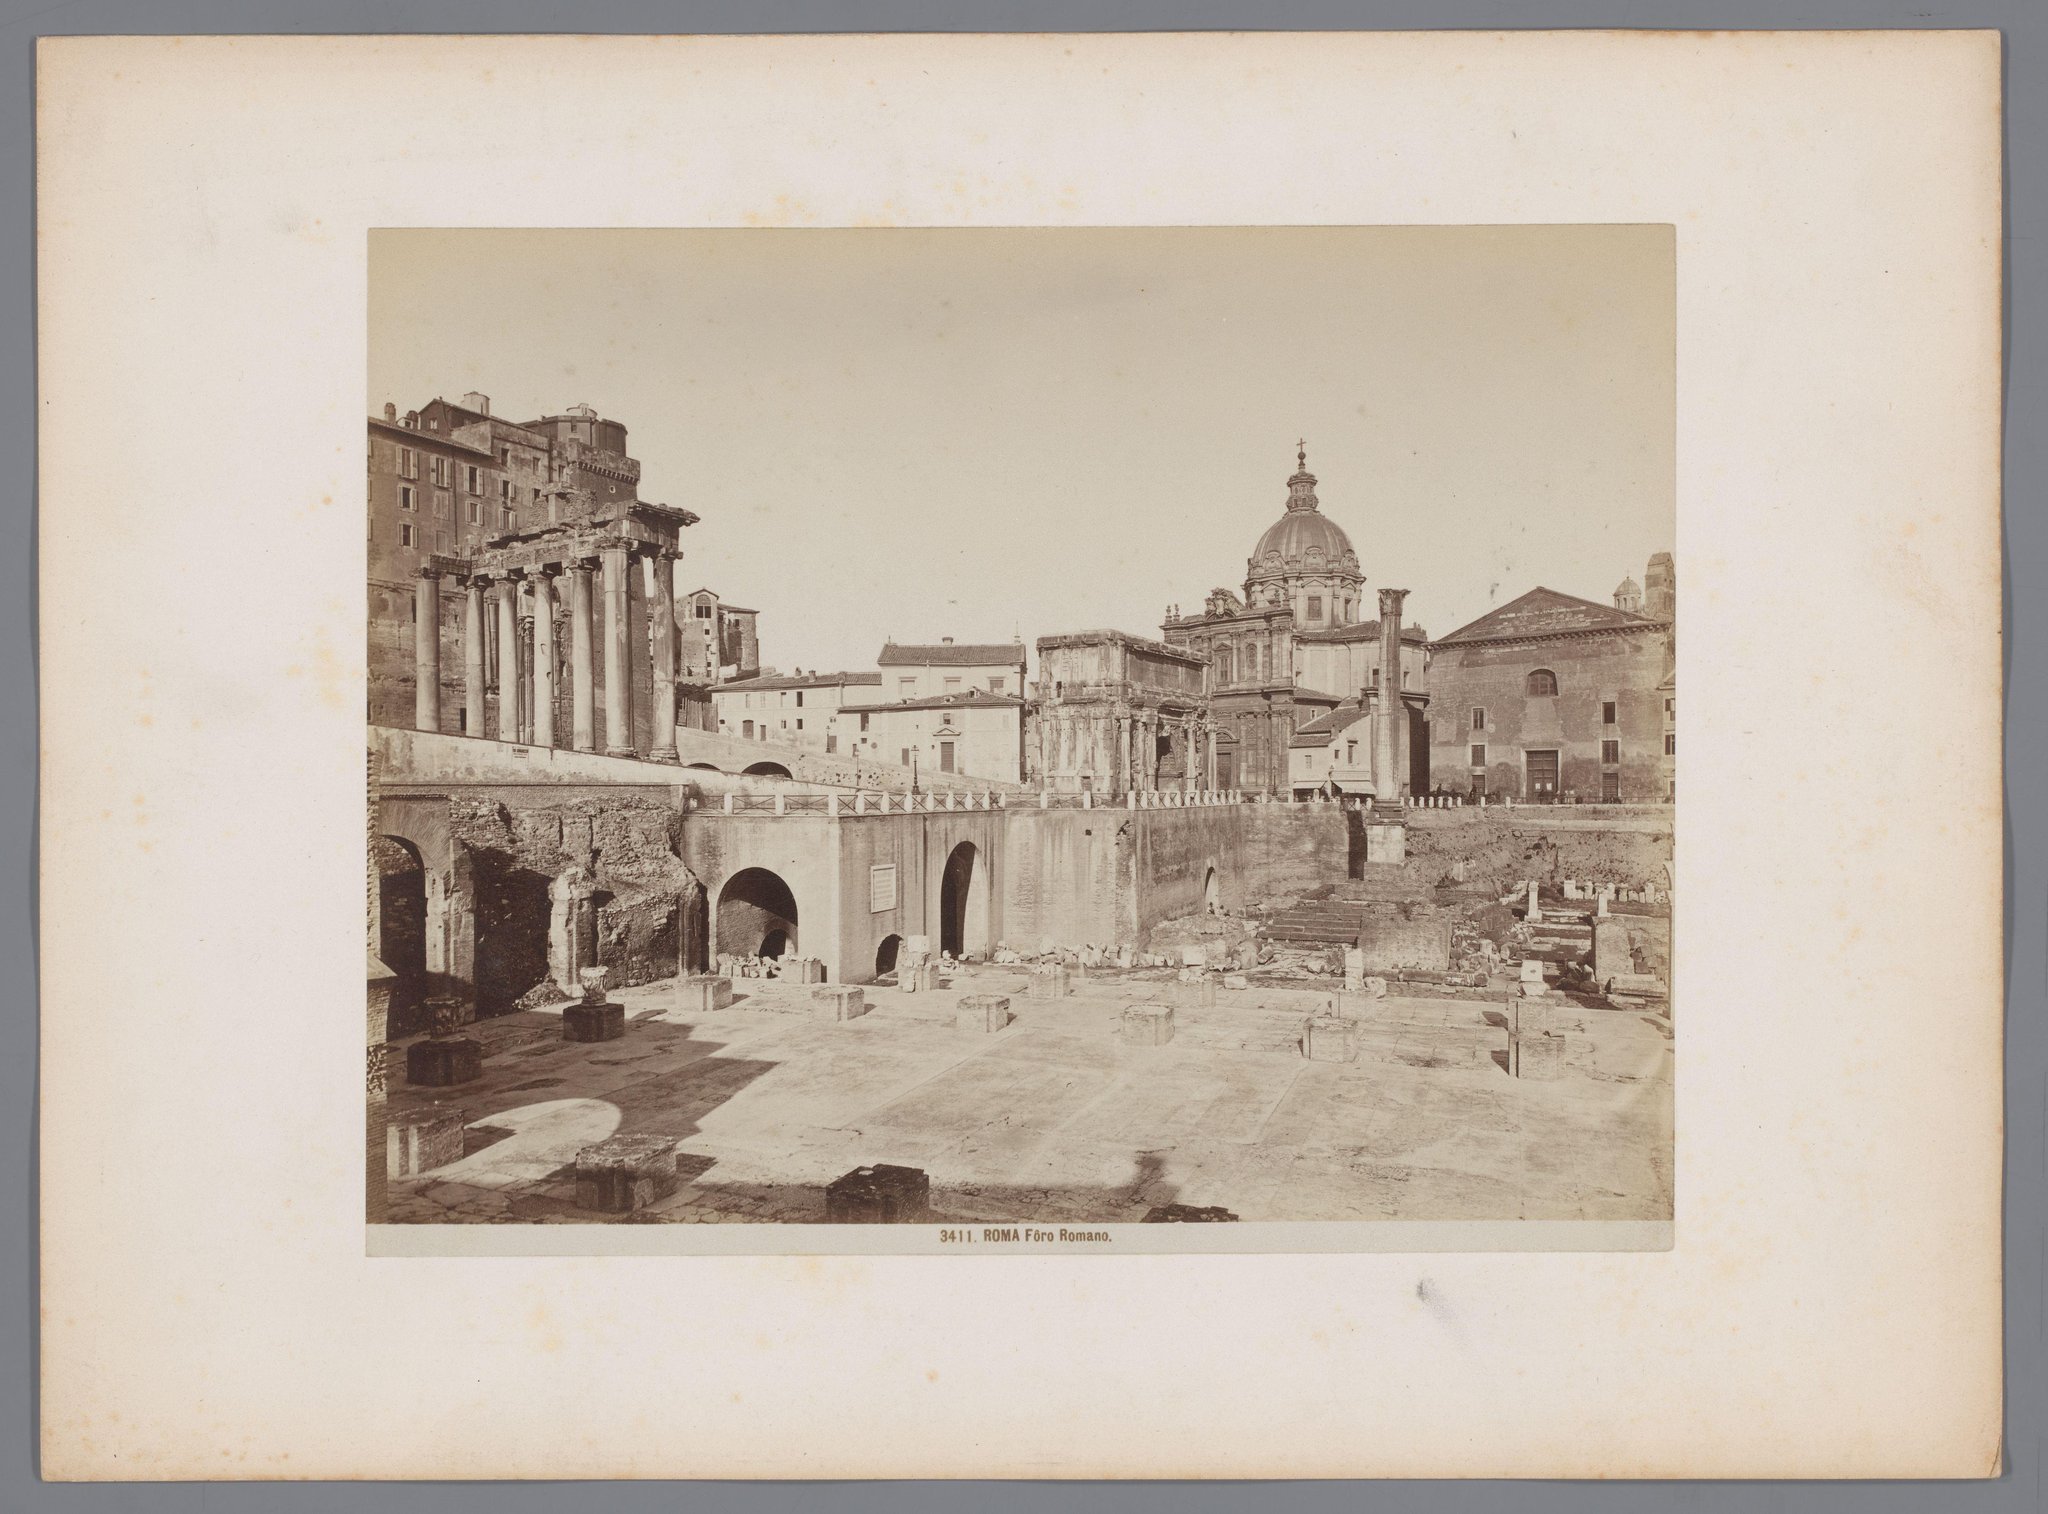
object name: photograph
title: Roma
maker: giacomo brogi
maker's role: fotograaf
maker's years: 1822-1881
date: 1864-1881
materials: cardboard, paper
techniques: albumen print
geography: rome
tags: landscape with ruins, excavation ~ archaeology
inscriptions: number: ‘9’, number: ‘3411.’, number: ‘53-’